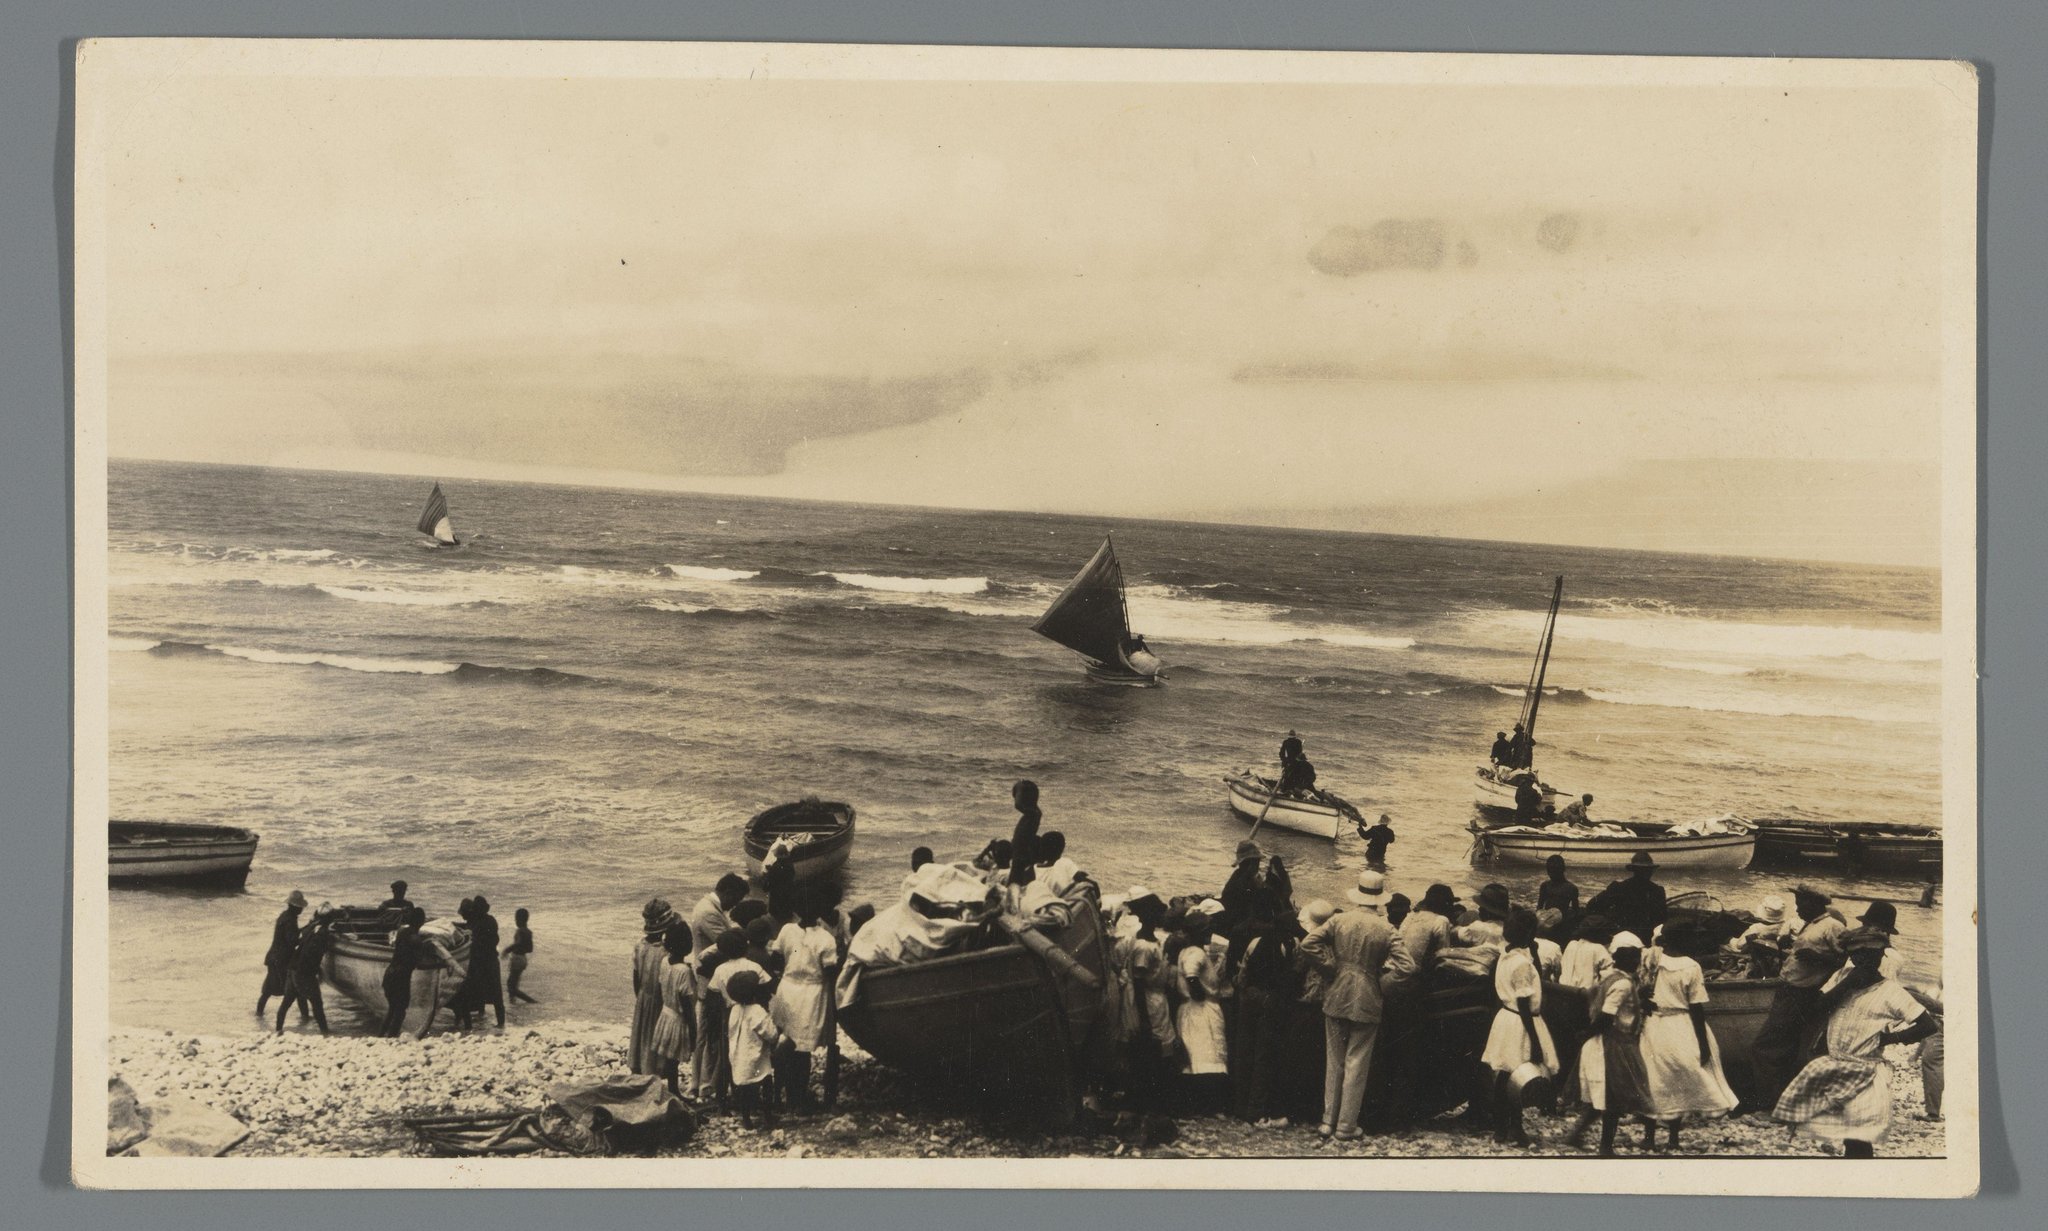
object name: photograph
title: Vissersboten aan de Surinaamse kust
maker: Anonymous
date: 1925-1927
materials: photographic support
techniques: photography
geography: suriname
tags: jetten, familie, moengo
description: Het binnenhalen van de vissersboten aan de kust. Onderdeel van het ensemble met foto's van de familie van ingenieur Jetten in de mijnbouwstad Moengo in Suriname.